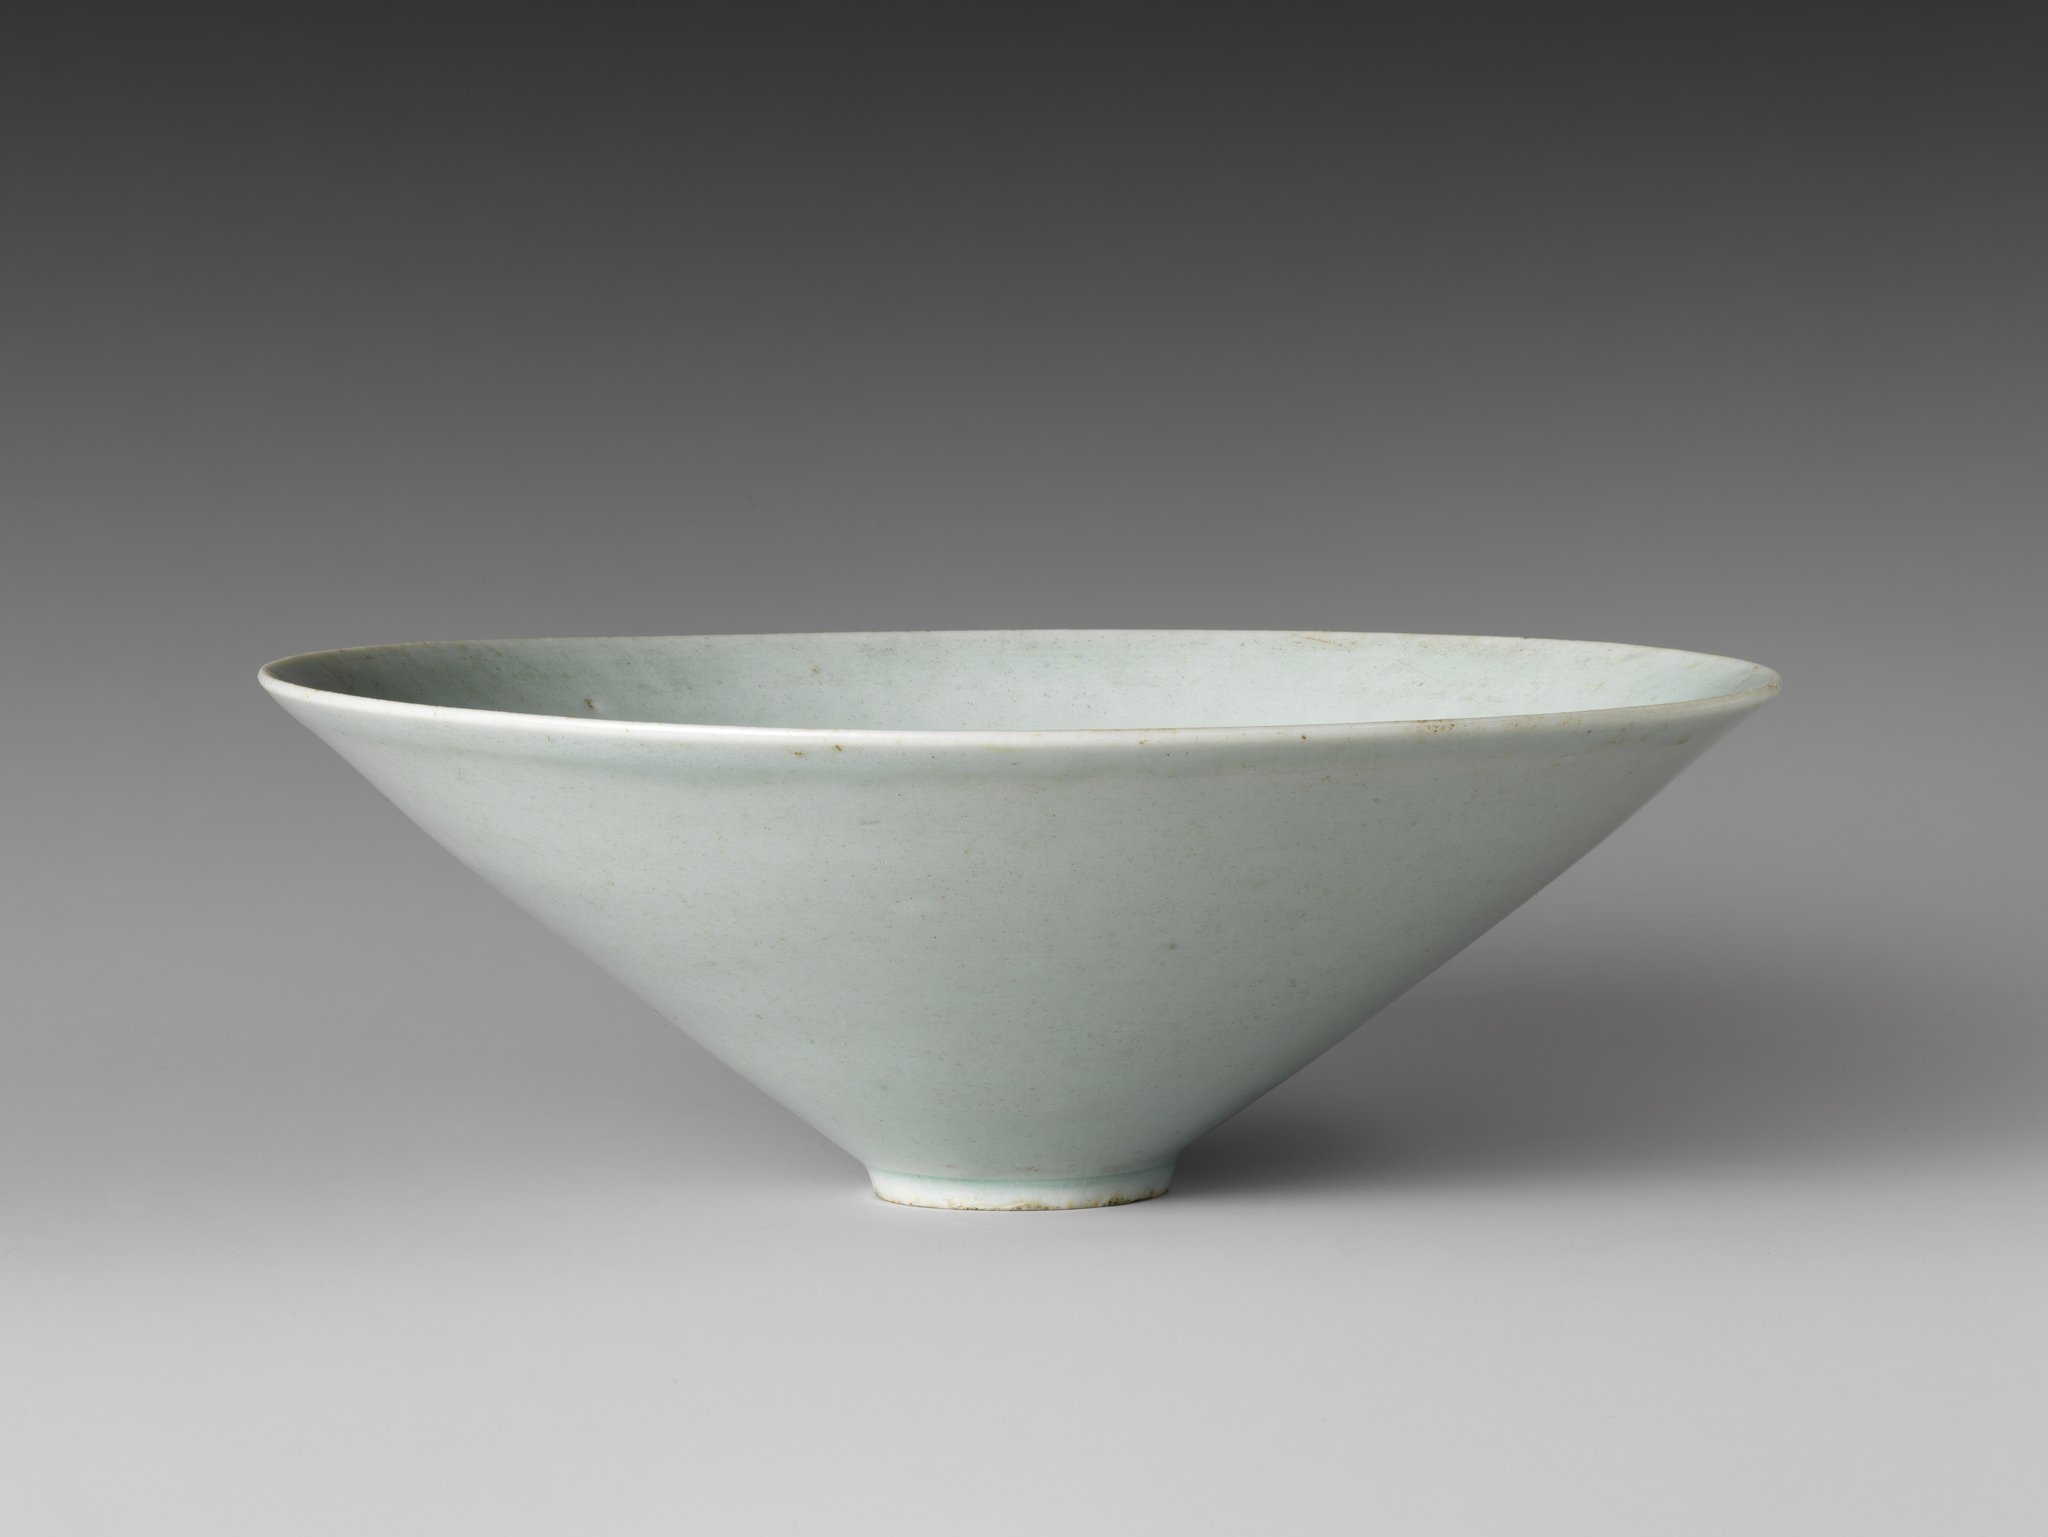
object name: bowl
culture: korean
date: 918-1392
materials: porcelain